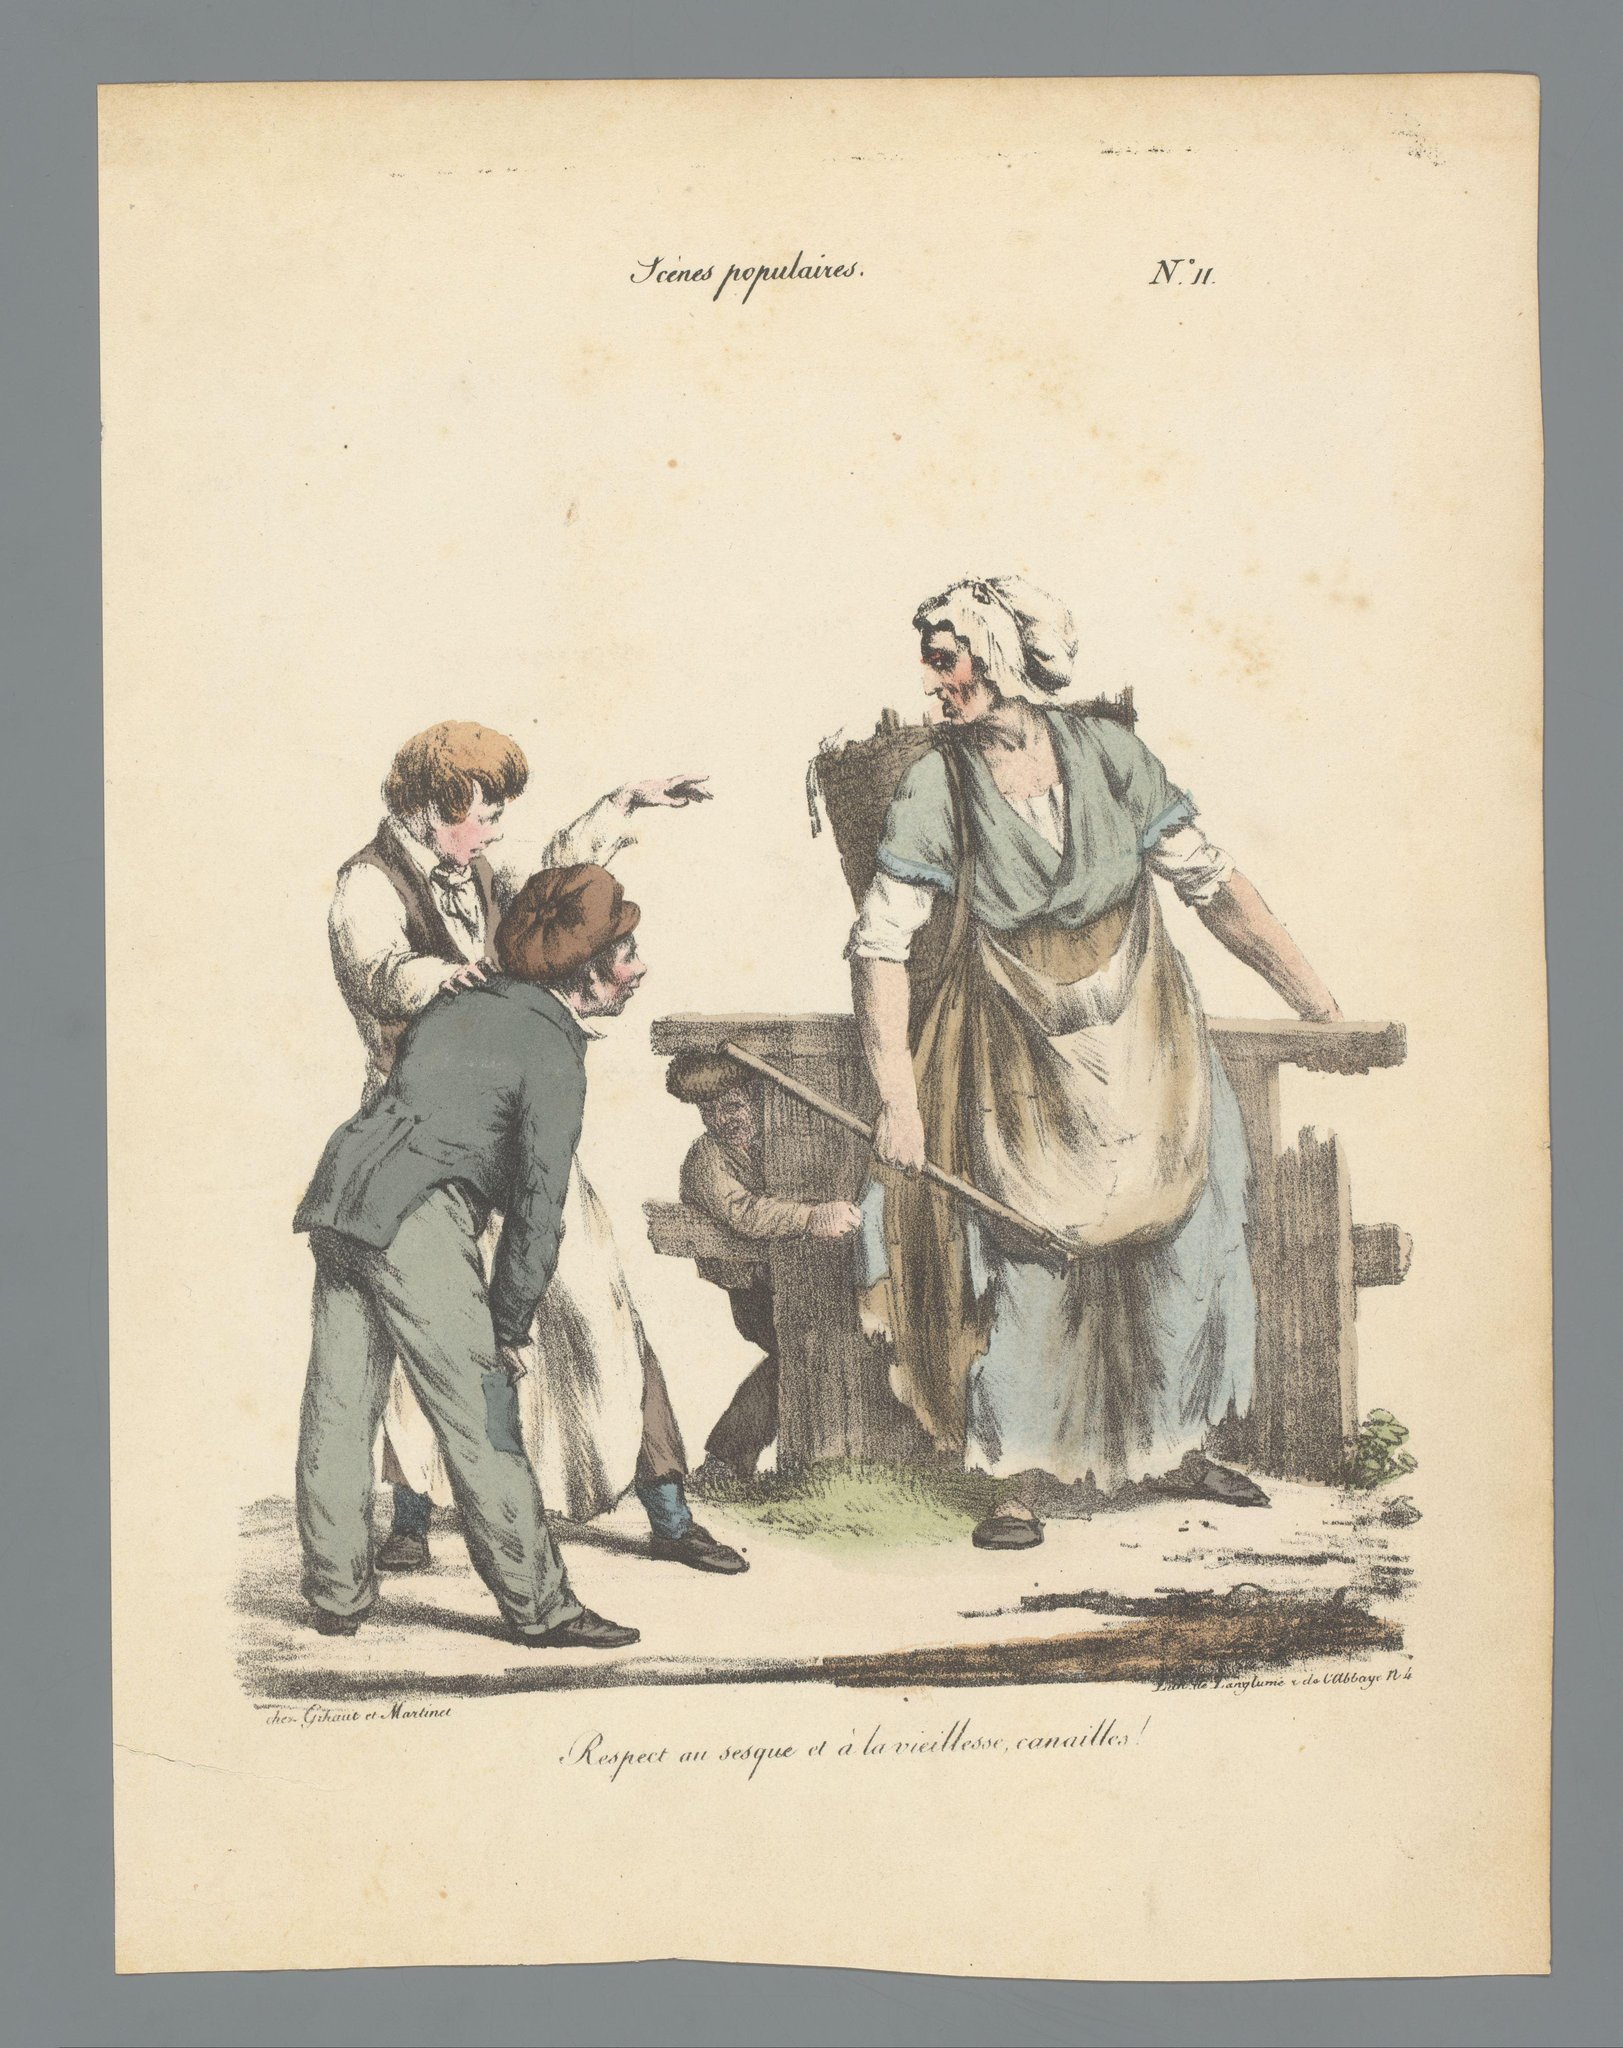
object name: print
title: Respect ou sesque et à la vieillesse, canailles!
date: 1822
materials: paper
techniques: hand coloring, lithograph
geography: paris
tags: adult woman, boy (child between toddler and youth), working class, labourers, mocking, insulting; teasing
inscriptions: inscription: ‘v. Stockum, 24 Nov. 1964/ No. 172 (81 st.) f. 520.-’, collector's mark: Lugt 2228, stamp: ‘L.A. de Vries’